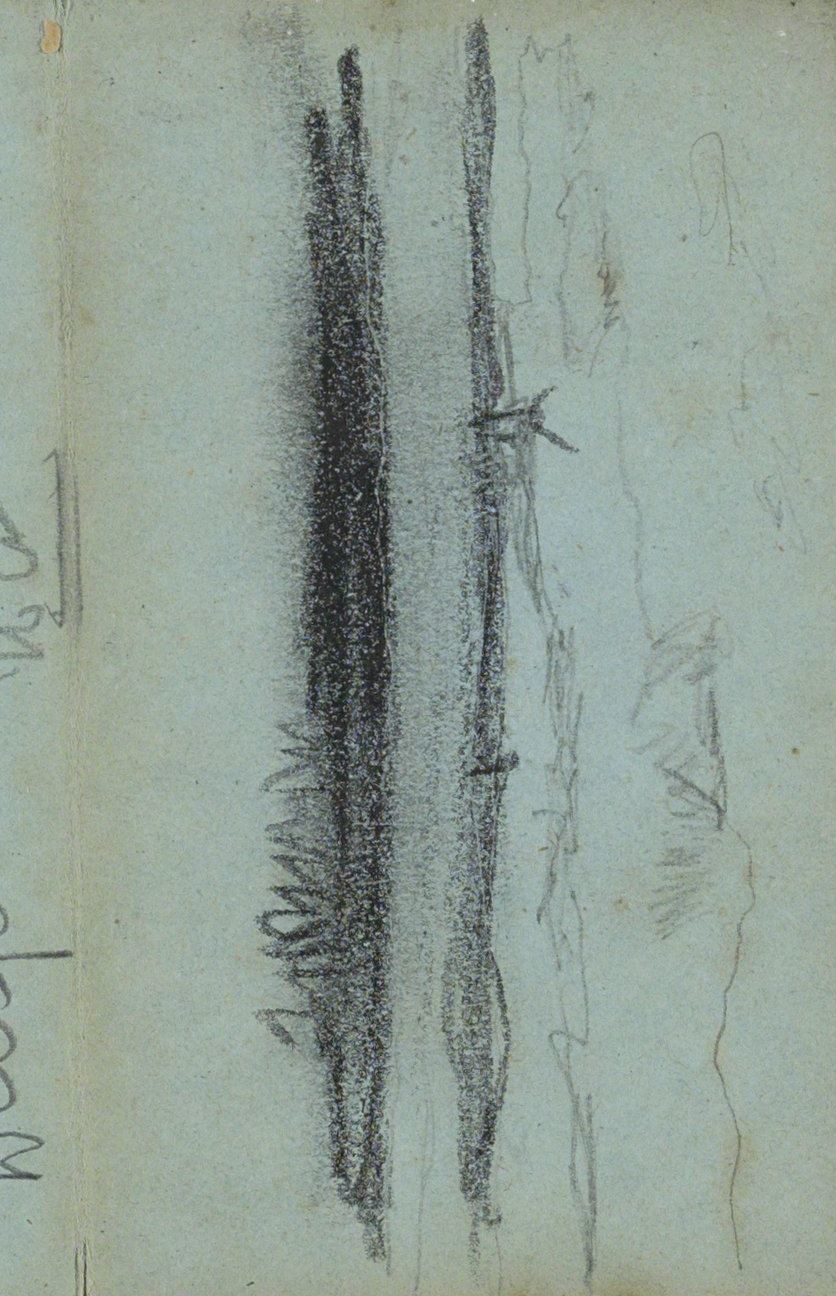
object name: sketchbook leaf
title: Landschap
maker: johan hendrik weissenbruch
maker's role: draughtsman, painter, print maker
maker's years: 1824-1903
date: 1834-1903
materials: chalk, paper, pencil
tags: landscapes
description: Recto-zijde van het voorste vrije schutblad uit een schetsboek met 32 bladen.